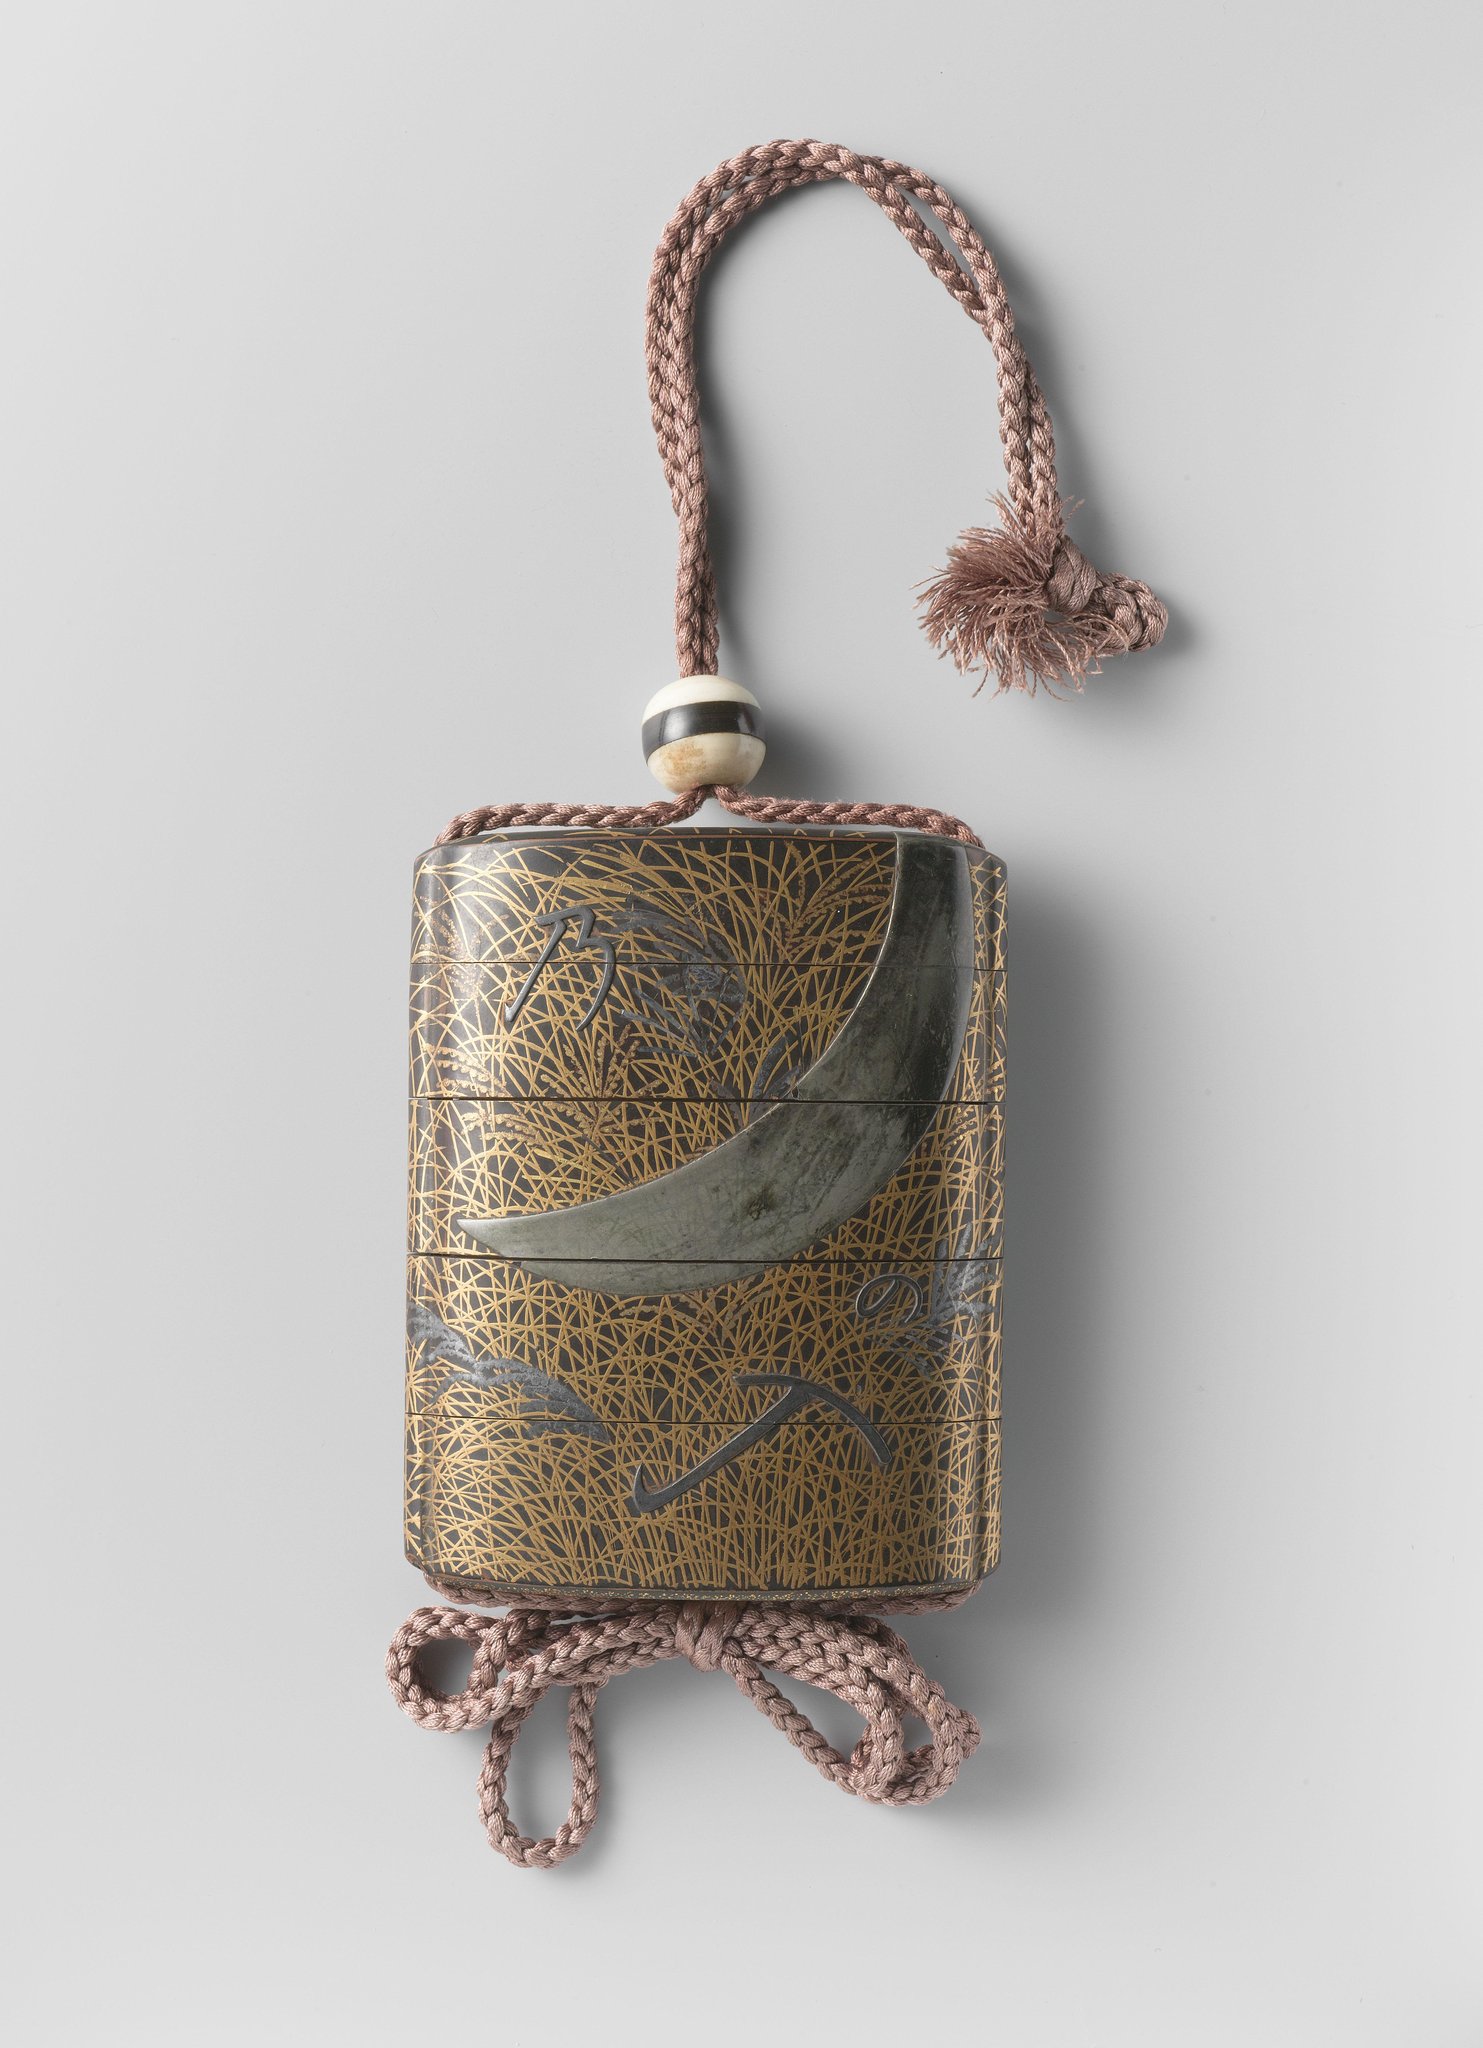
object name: inrō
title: Inro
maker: Anonymous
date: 1700-1800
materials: lacquer, wood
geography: japan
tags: waxing moon, i.e. facing this way: )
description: Decoratie met suzuki-gras in goud tegen een zwarte achtergrond. Tevens een maansikkel in zilverlak en een gedicht. Vijf doosjes met touw verbonden.